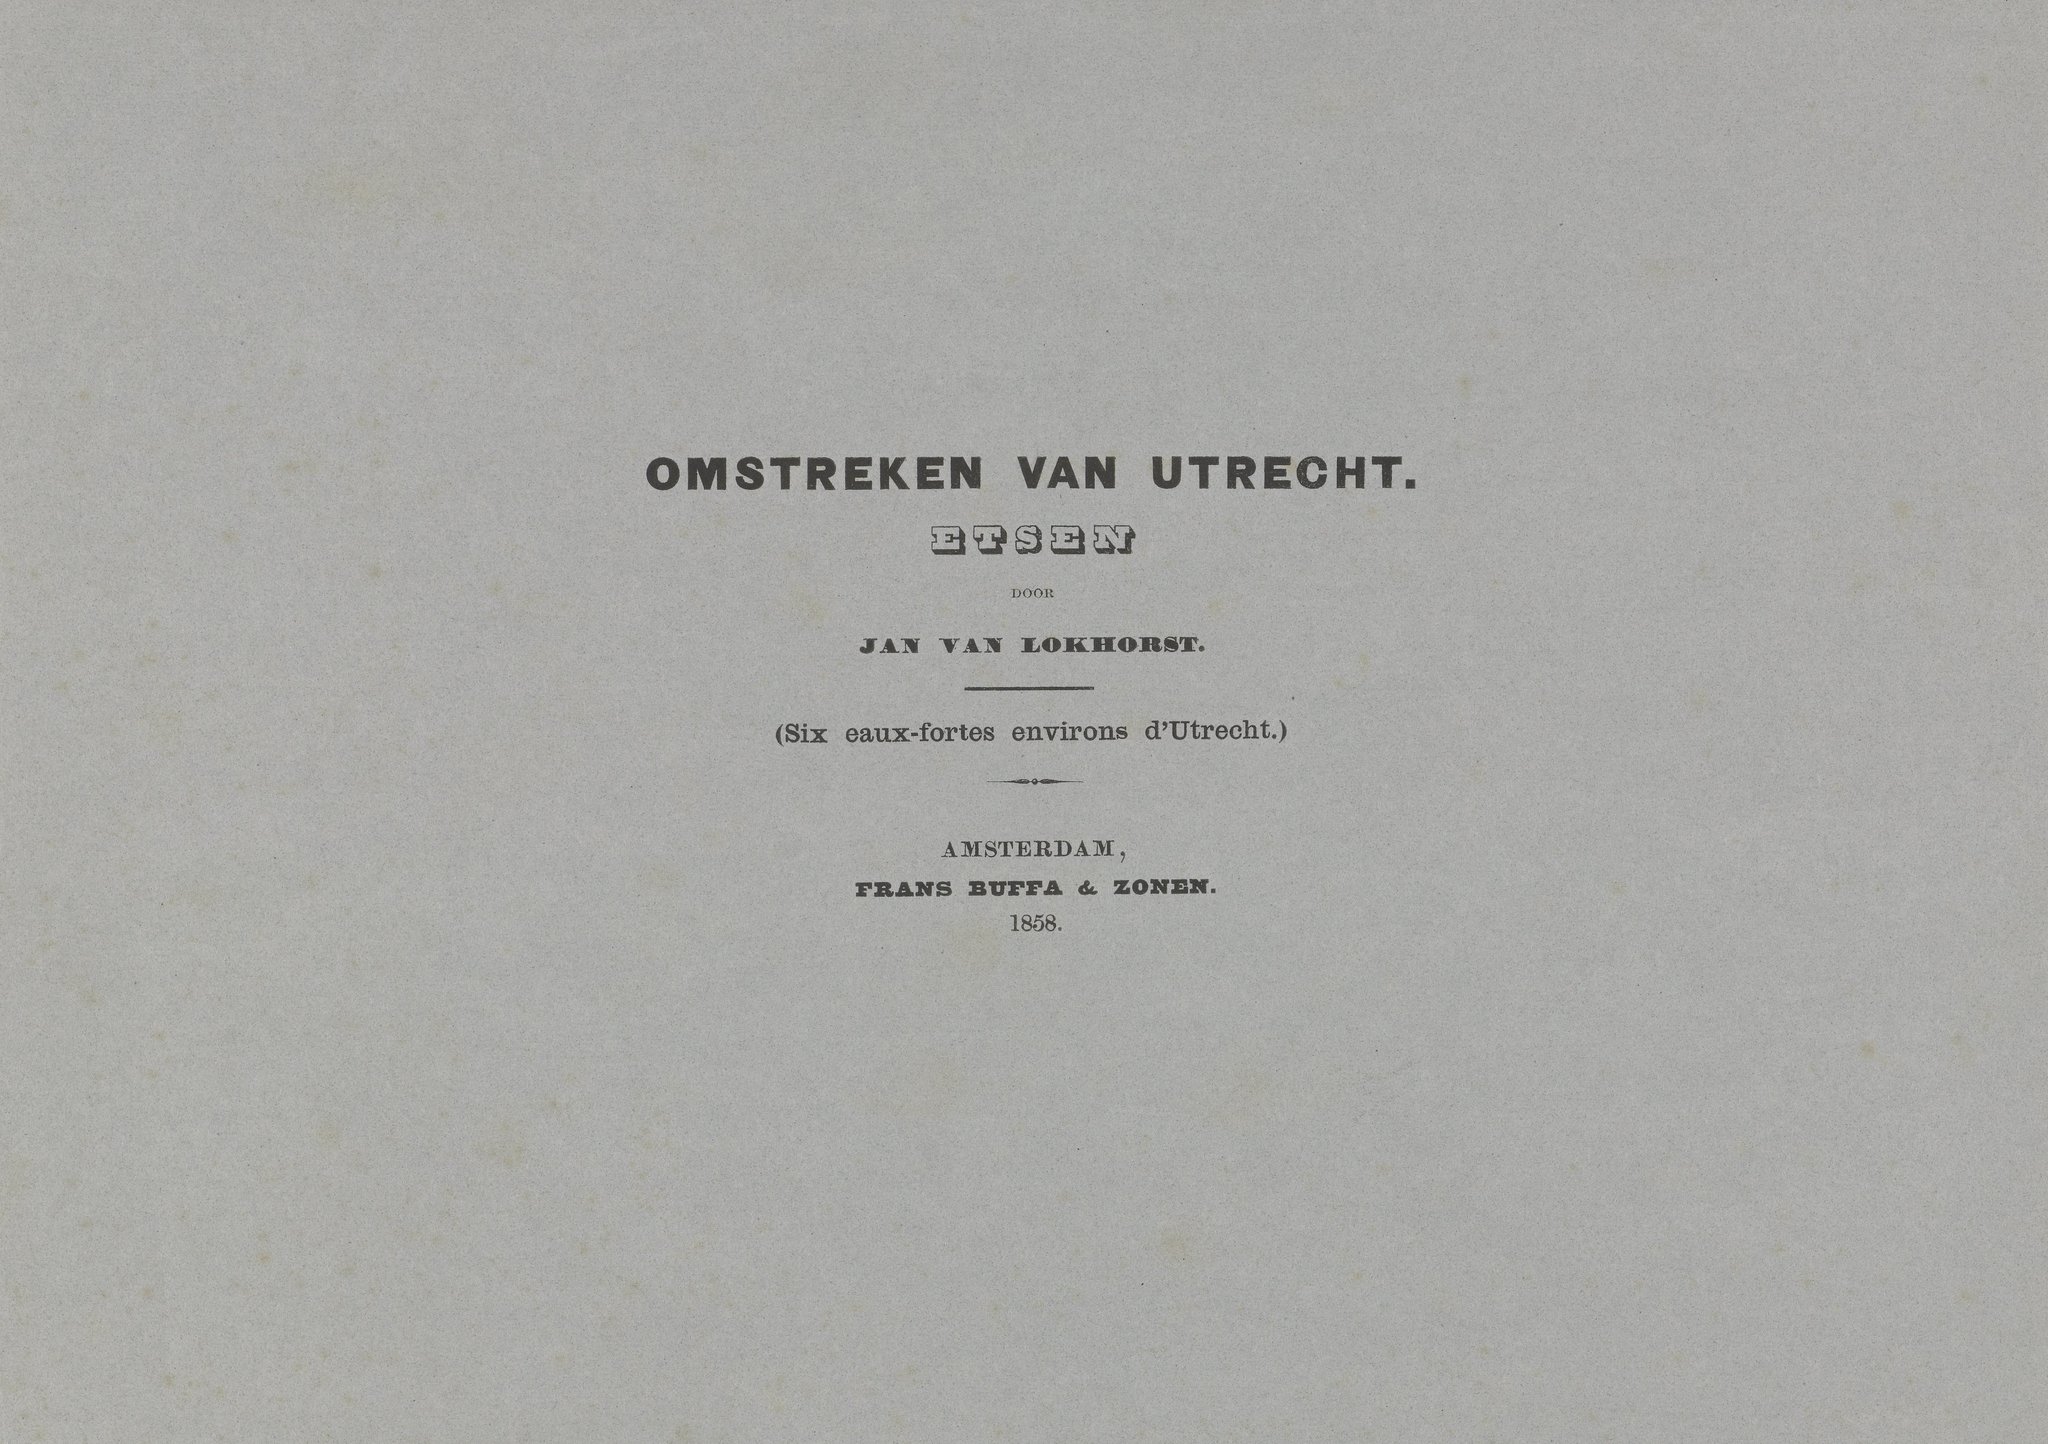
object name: text sheet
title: Omstreken van Utrecht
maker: jan van lokhorst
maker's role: draughtsman, print maker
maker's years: 1837-1894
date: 1858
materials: paper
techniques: letterpress printing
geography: amsterdam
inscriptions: collector's mark: Lugt 2228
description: Tekstblad voor serie prenten met gezichten buiten Utrecht. Met titel in het Nederlands en Frans.